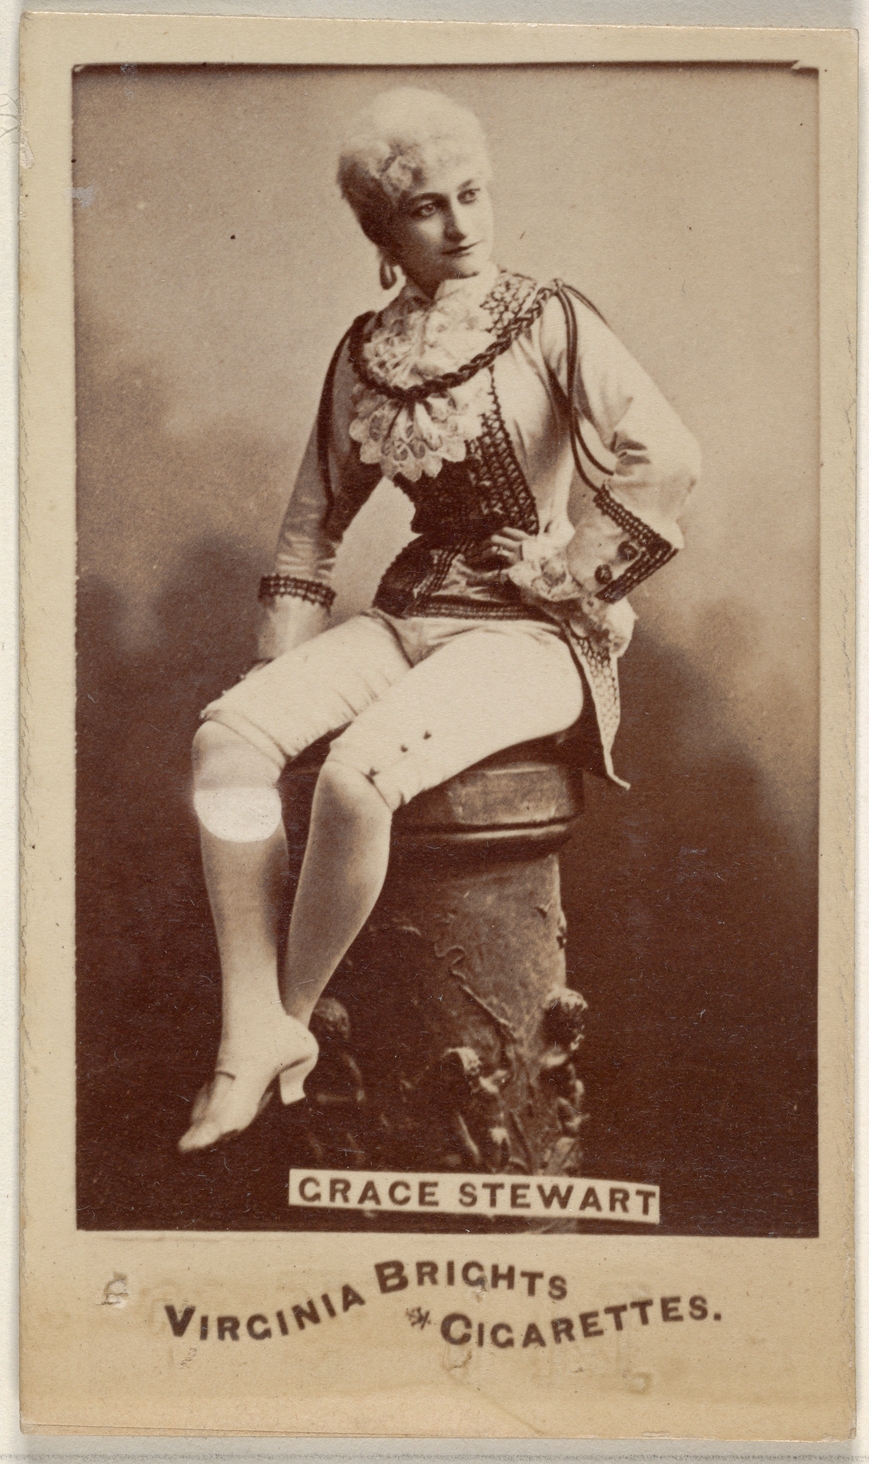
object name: photograph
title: Grace Stewart, from the Actors and Actresses series (N45, Type 6) for Virginia Brights Cigarettes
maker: allen & ginter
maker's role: publisher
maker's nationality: american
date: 1888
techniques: albumen silver print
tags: portraits,women,actresses